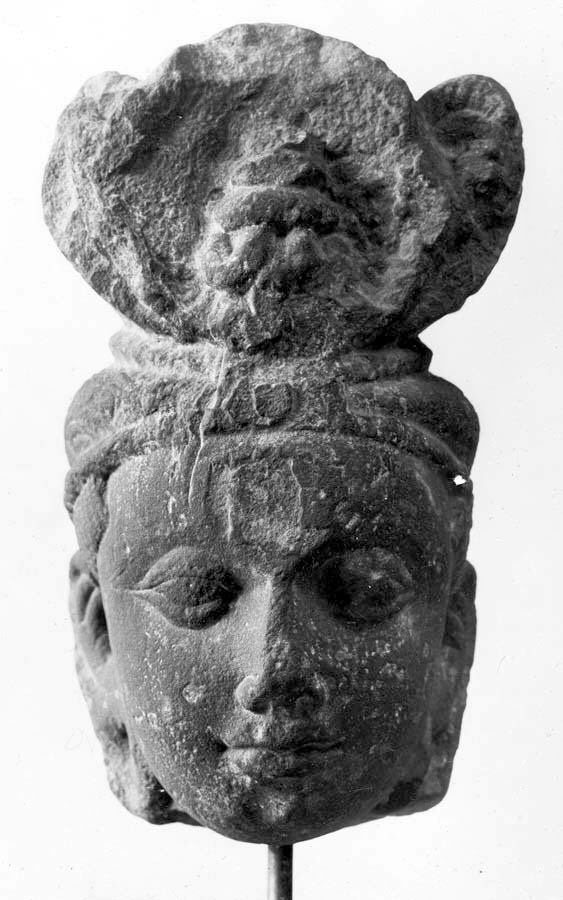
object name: head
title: Head of a Bodhisattva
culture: indian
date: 351-400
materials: stone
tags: kushan,mathura,faces,heads,bodhisattvas,buddha